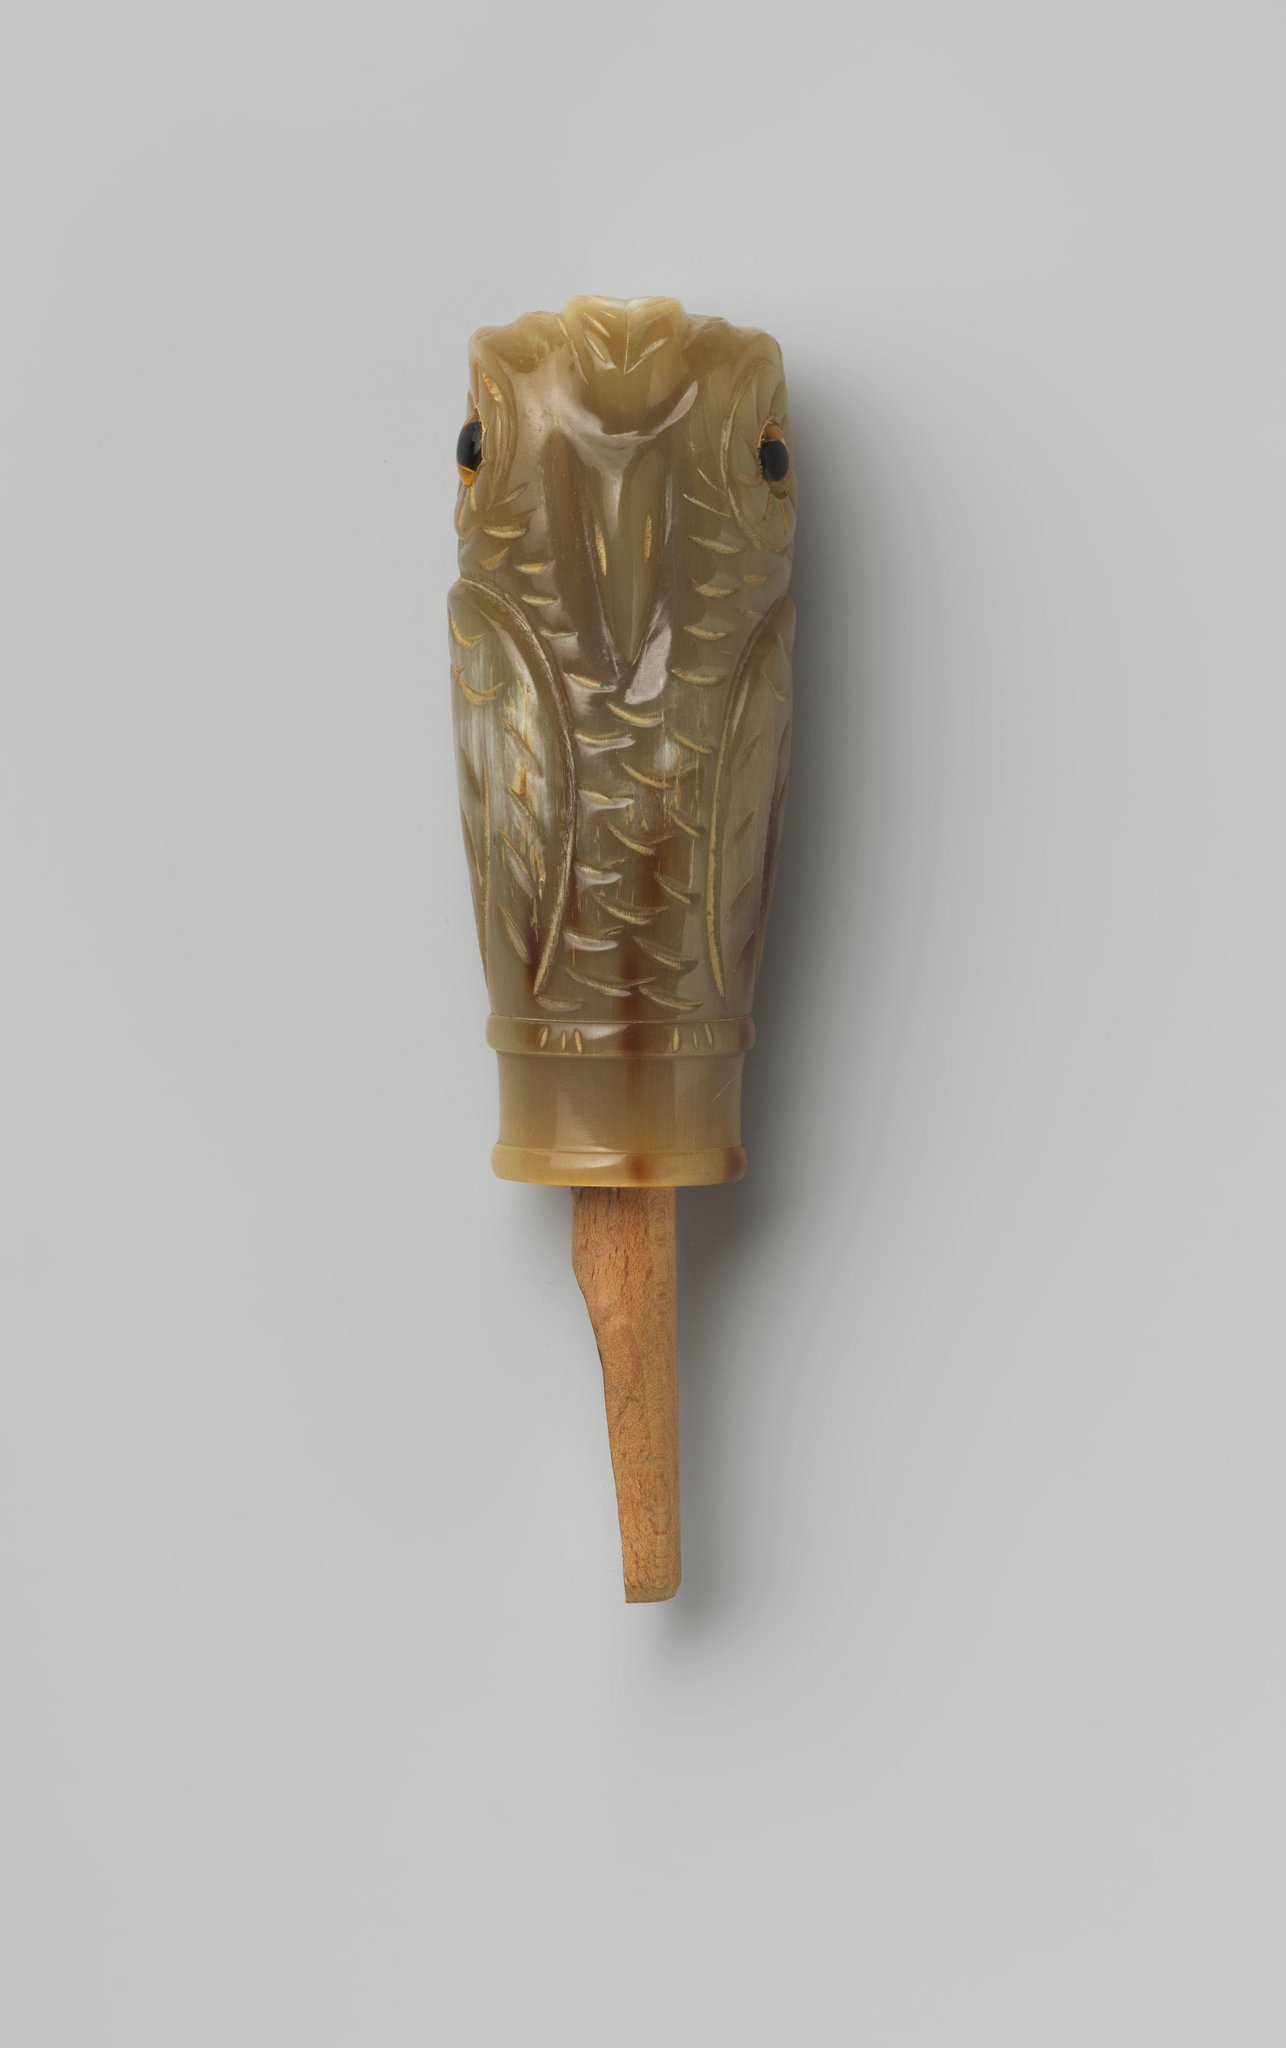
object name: haakknop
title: Knop van biege hoorn in de vorm van een uil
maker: Anonymous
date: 1900-1930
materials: glass, horn, wood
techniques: manufacturing, cutting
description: Knop van biege hoorn in de vorm van een uil, in reliëf gesneden, met gele ogen van glas. Met houten pin.